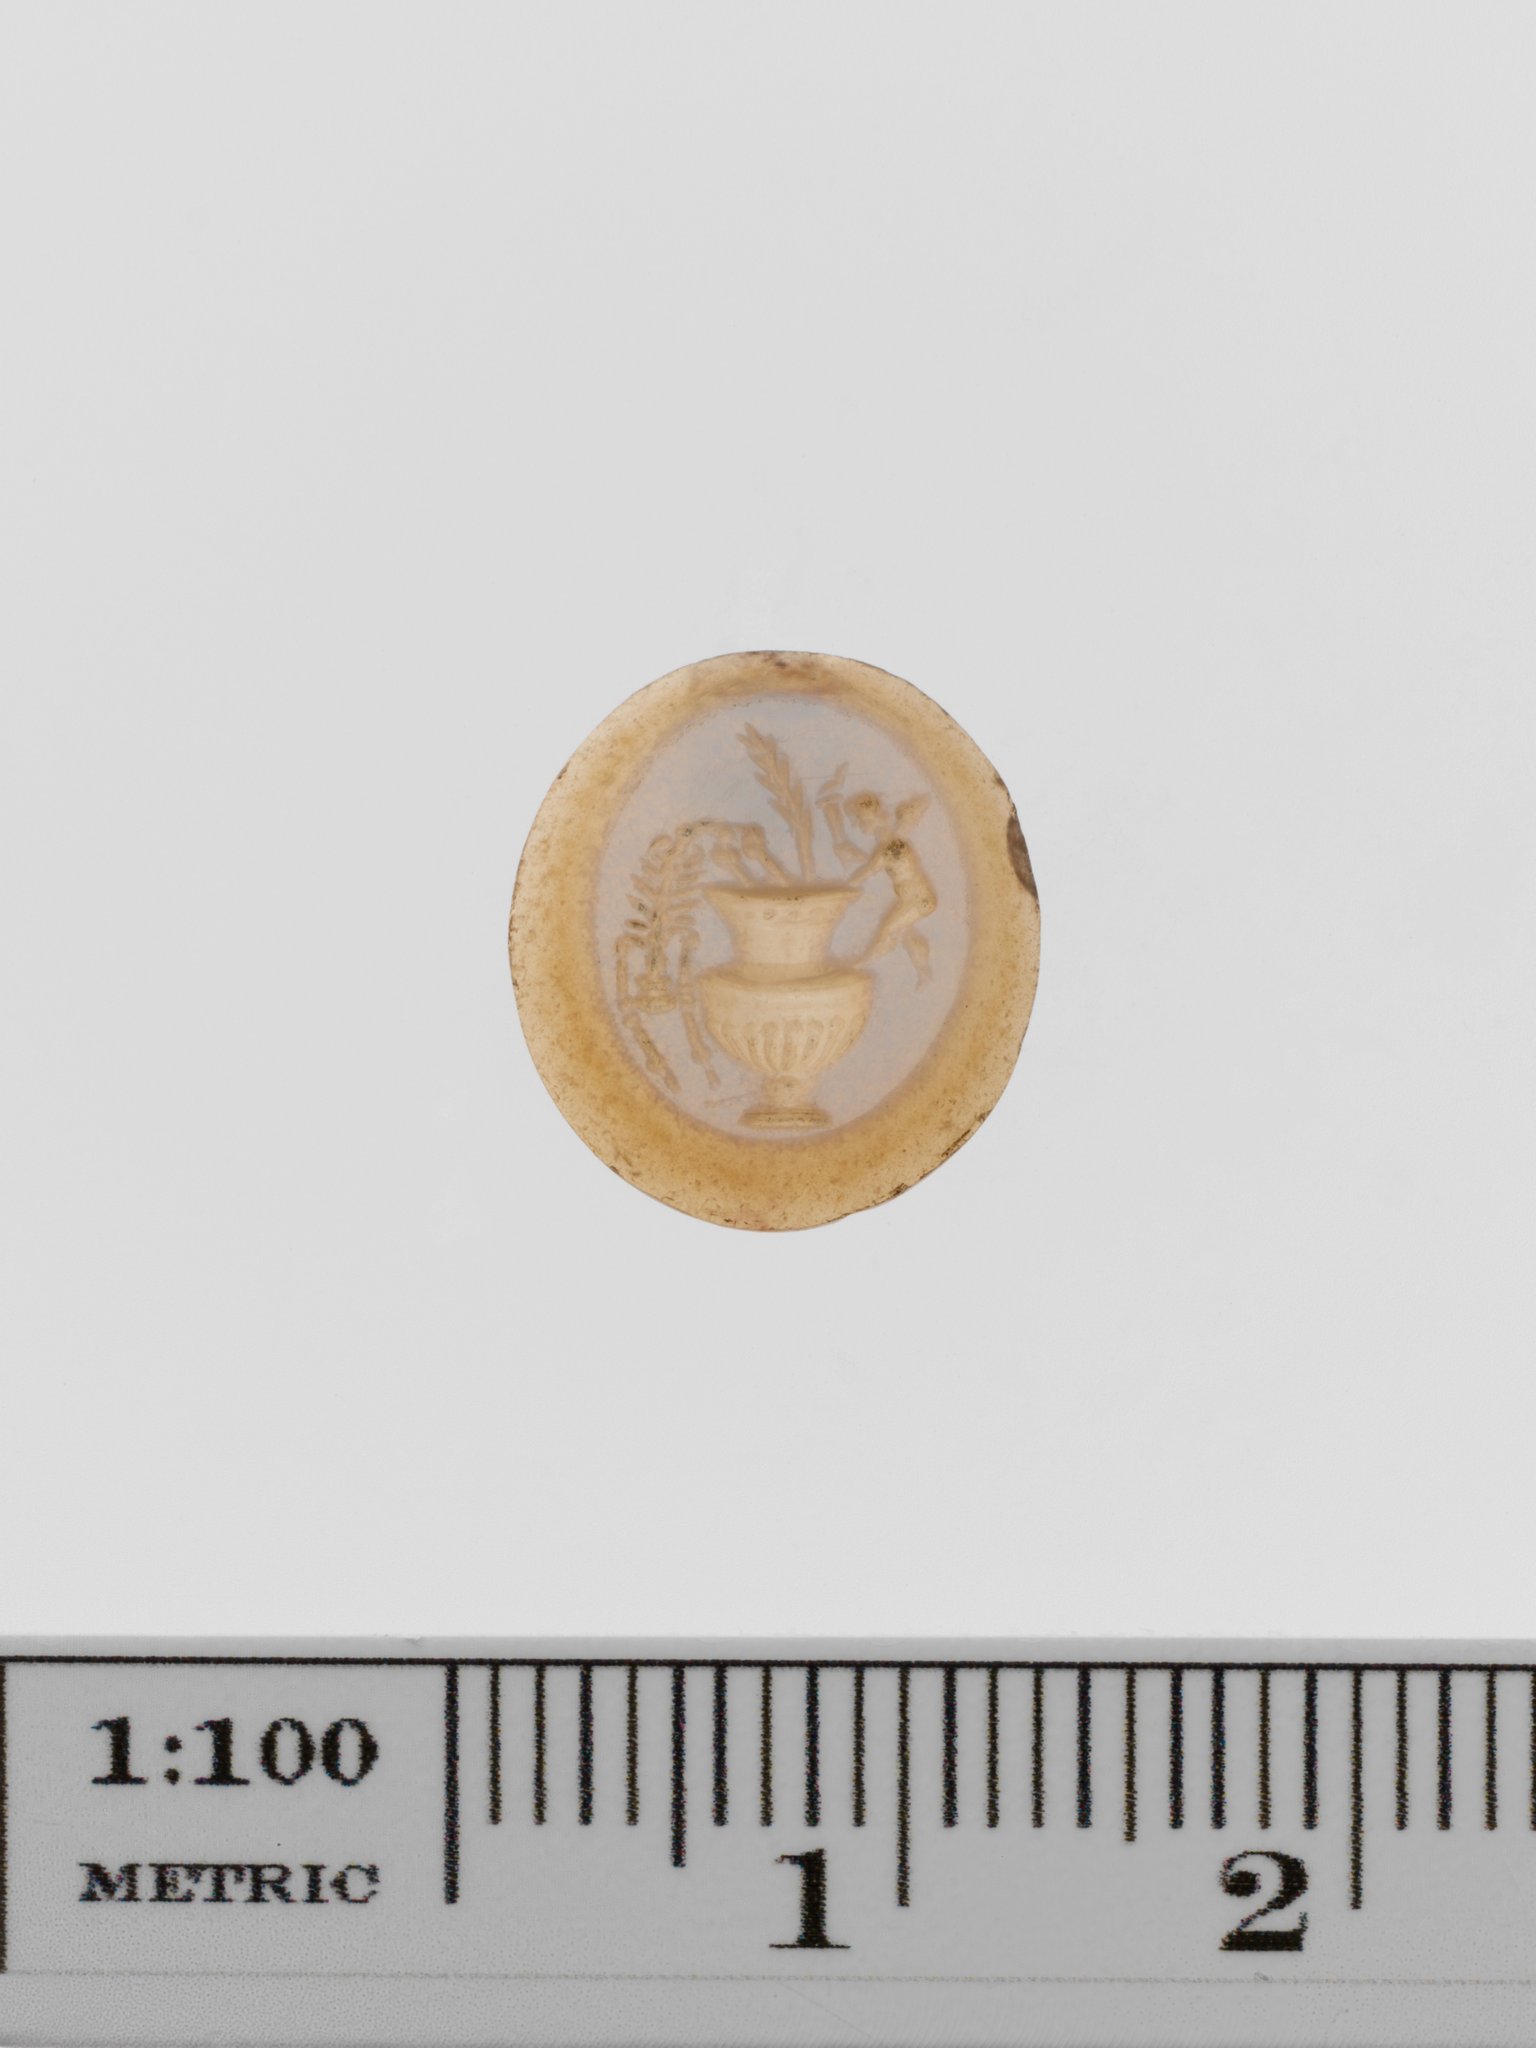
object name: intaglio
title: Onyx ring stone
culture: roman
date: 1-100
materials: onyx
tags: skeletons,eros